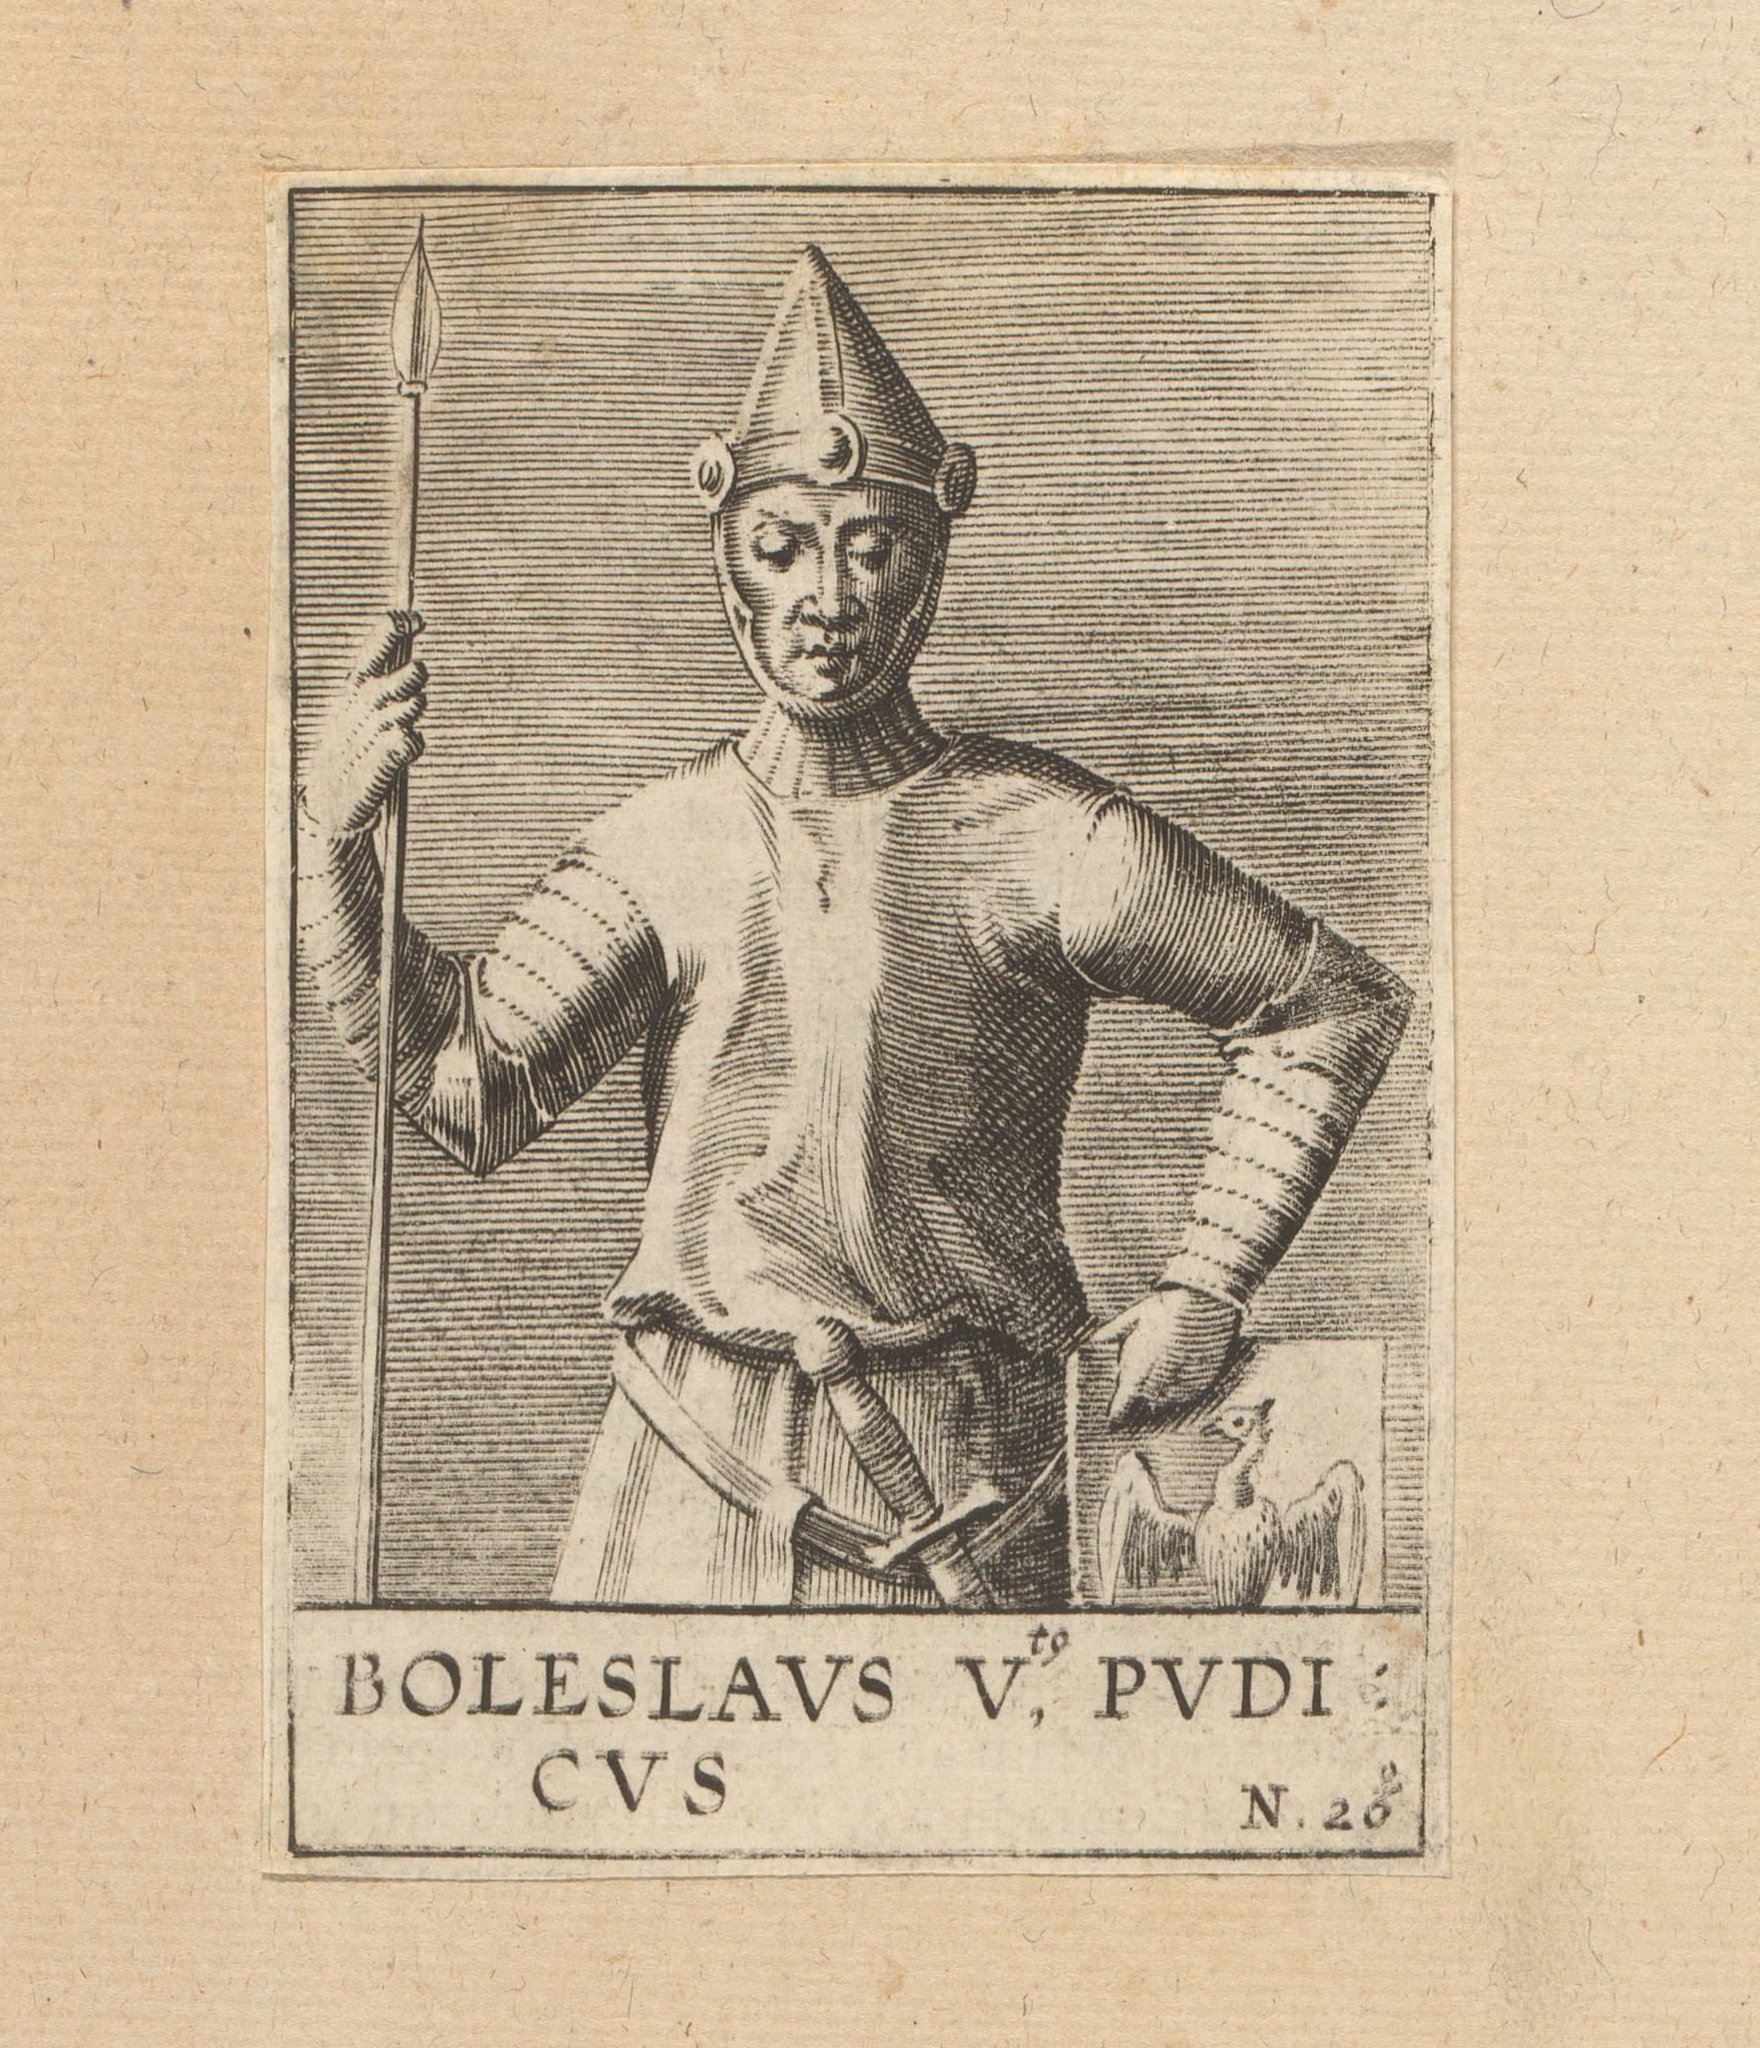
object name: print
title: Portret van Boleslaw V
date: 1574-1594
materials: paper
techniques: woodcut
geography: cologne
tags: historical persons, ruler, sovereign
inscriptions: collector's mark: Lugt 240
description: Prent gebruikt in: Mylius, Arnold. Principum et Regum Polonorum Imagines ad Vivum Expressae (...). Keulen: Gottfried von Kempen, 1594.